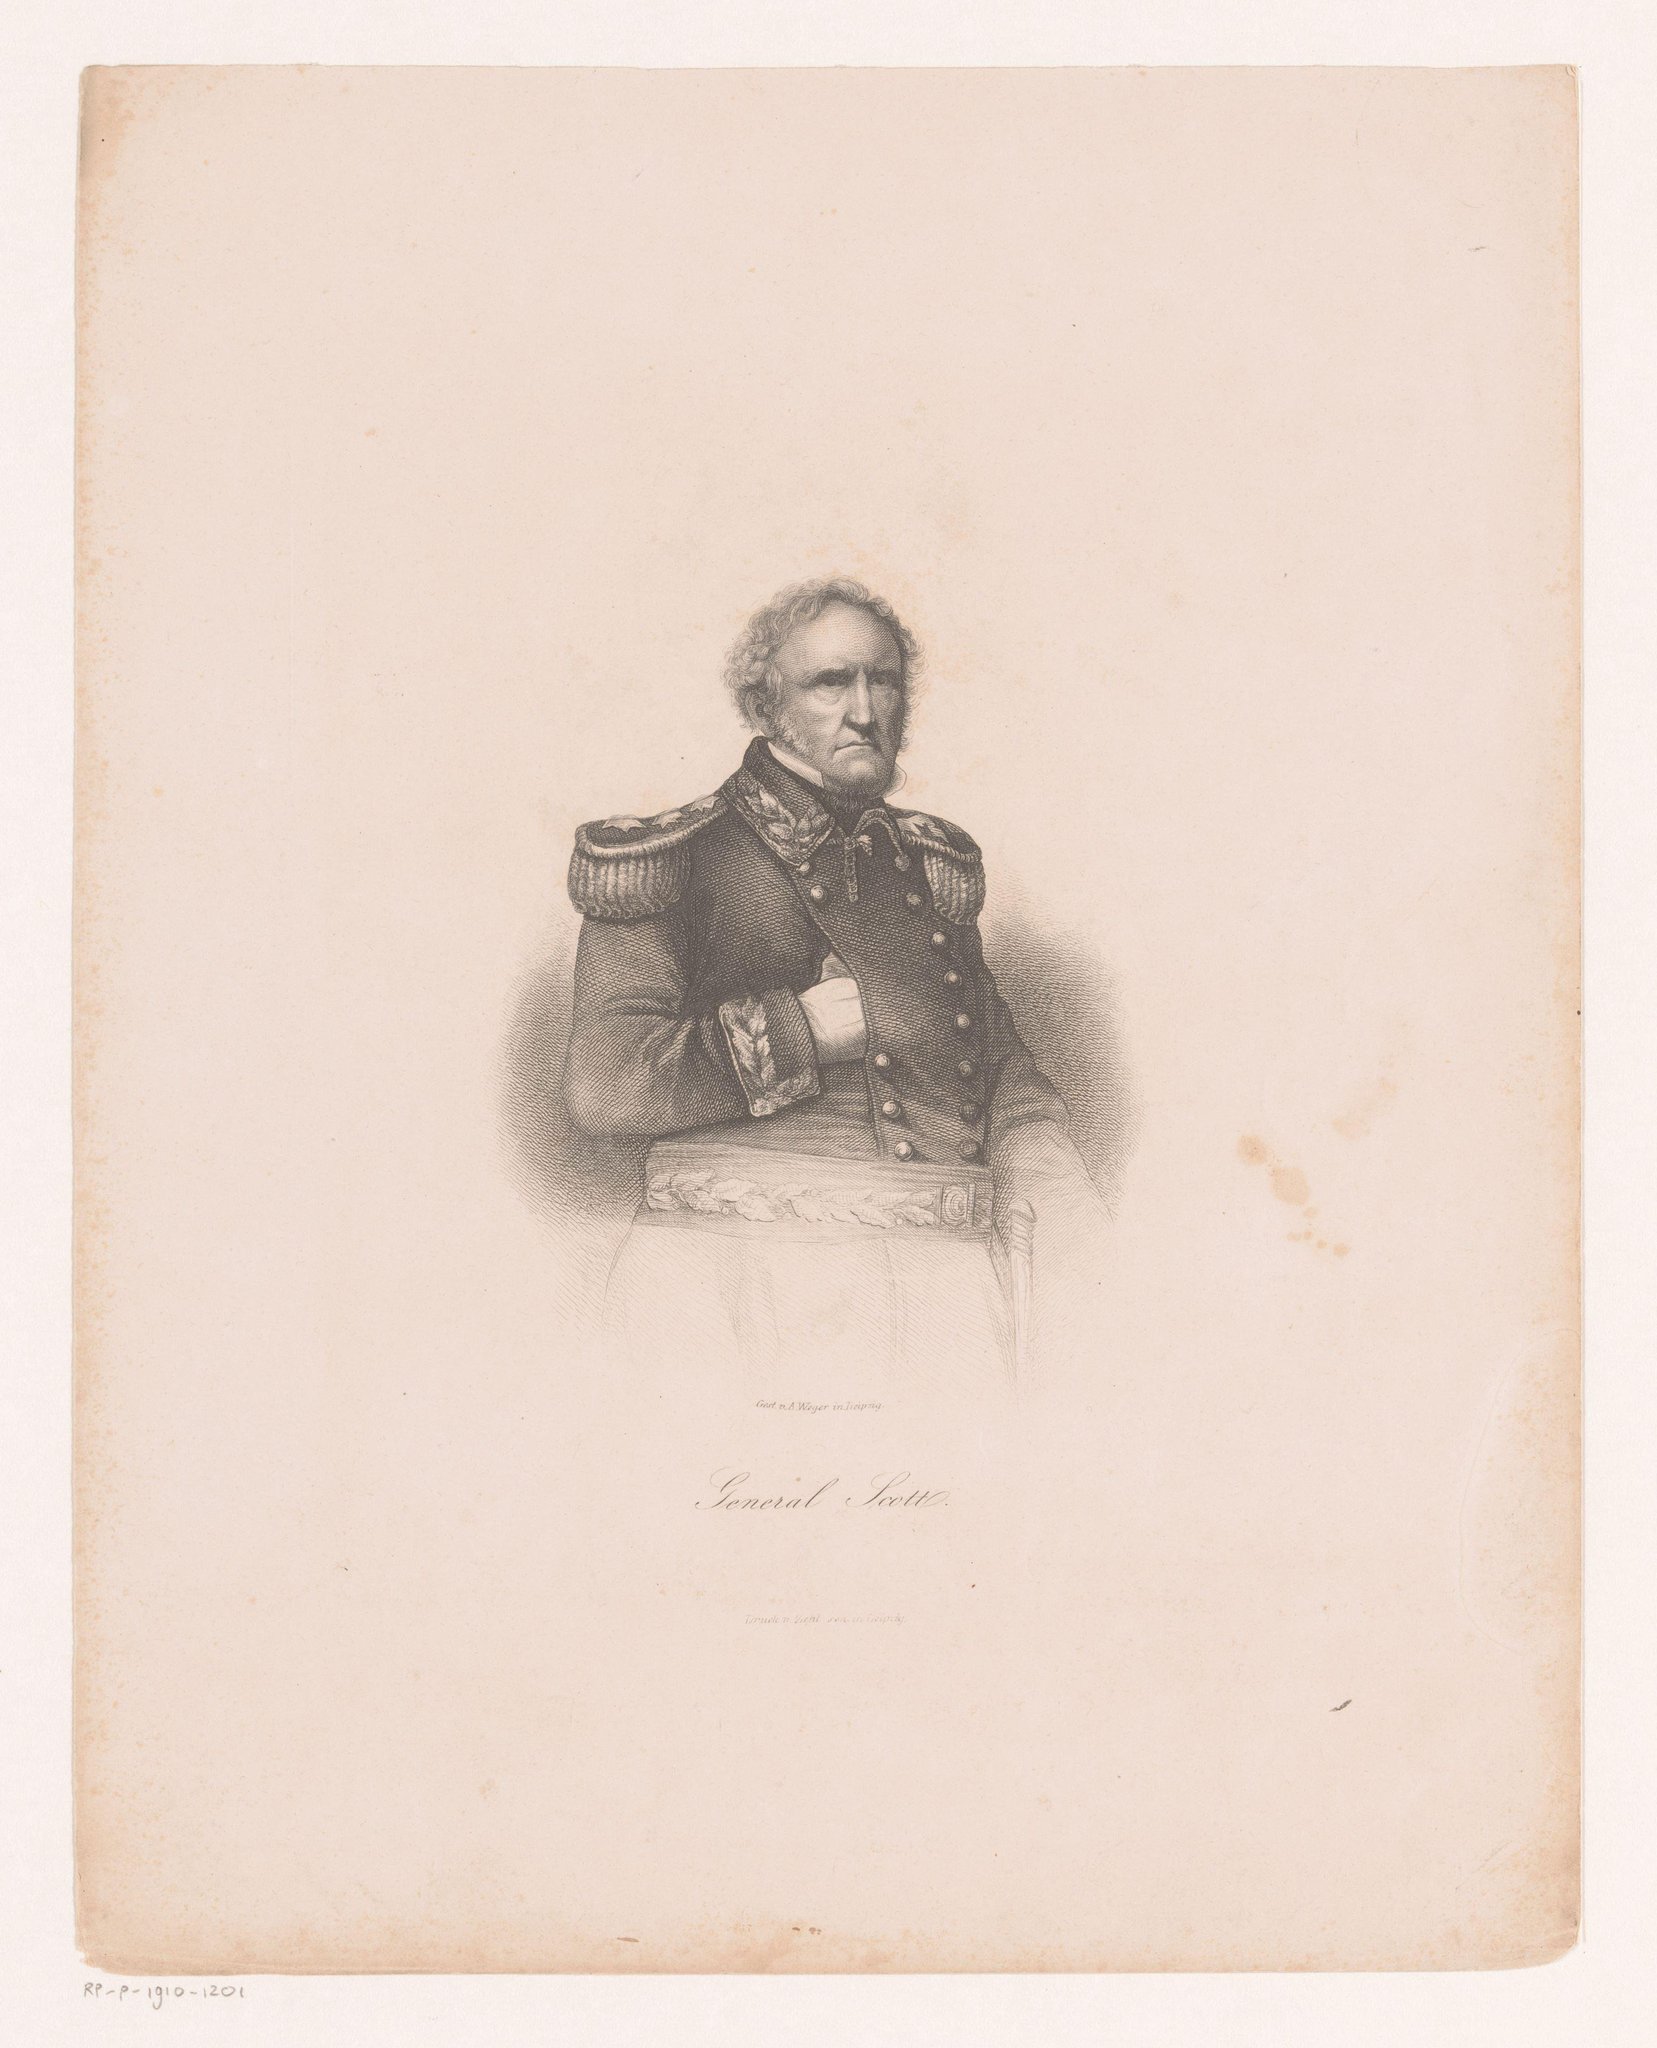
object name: print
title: Portret van Winfield Scott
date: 1849-1892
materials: paper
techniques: engraving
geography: leipzig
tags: historical persons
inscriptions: collector's mark: Lugt 2228